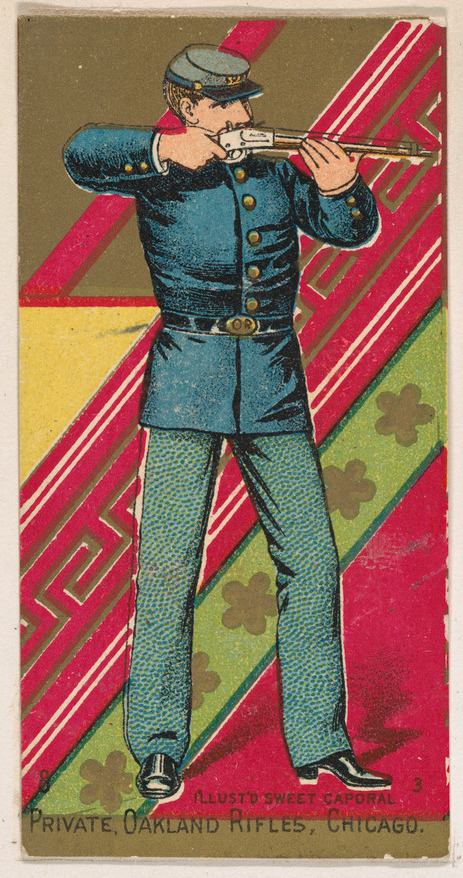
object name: print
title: Private, Oakland Rifles, Chicago, from the Military Series (N224) issued by Kinney Tobacco Company to promote Sweet Caporal Cigarettes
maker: kinney brothers tobacco company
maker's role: publisher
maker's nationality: american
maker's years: 1869-2011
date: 1888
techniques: color lithograph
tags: military,firearms,men,profiles